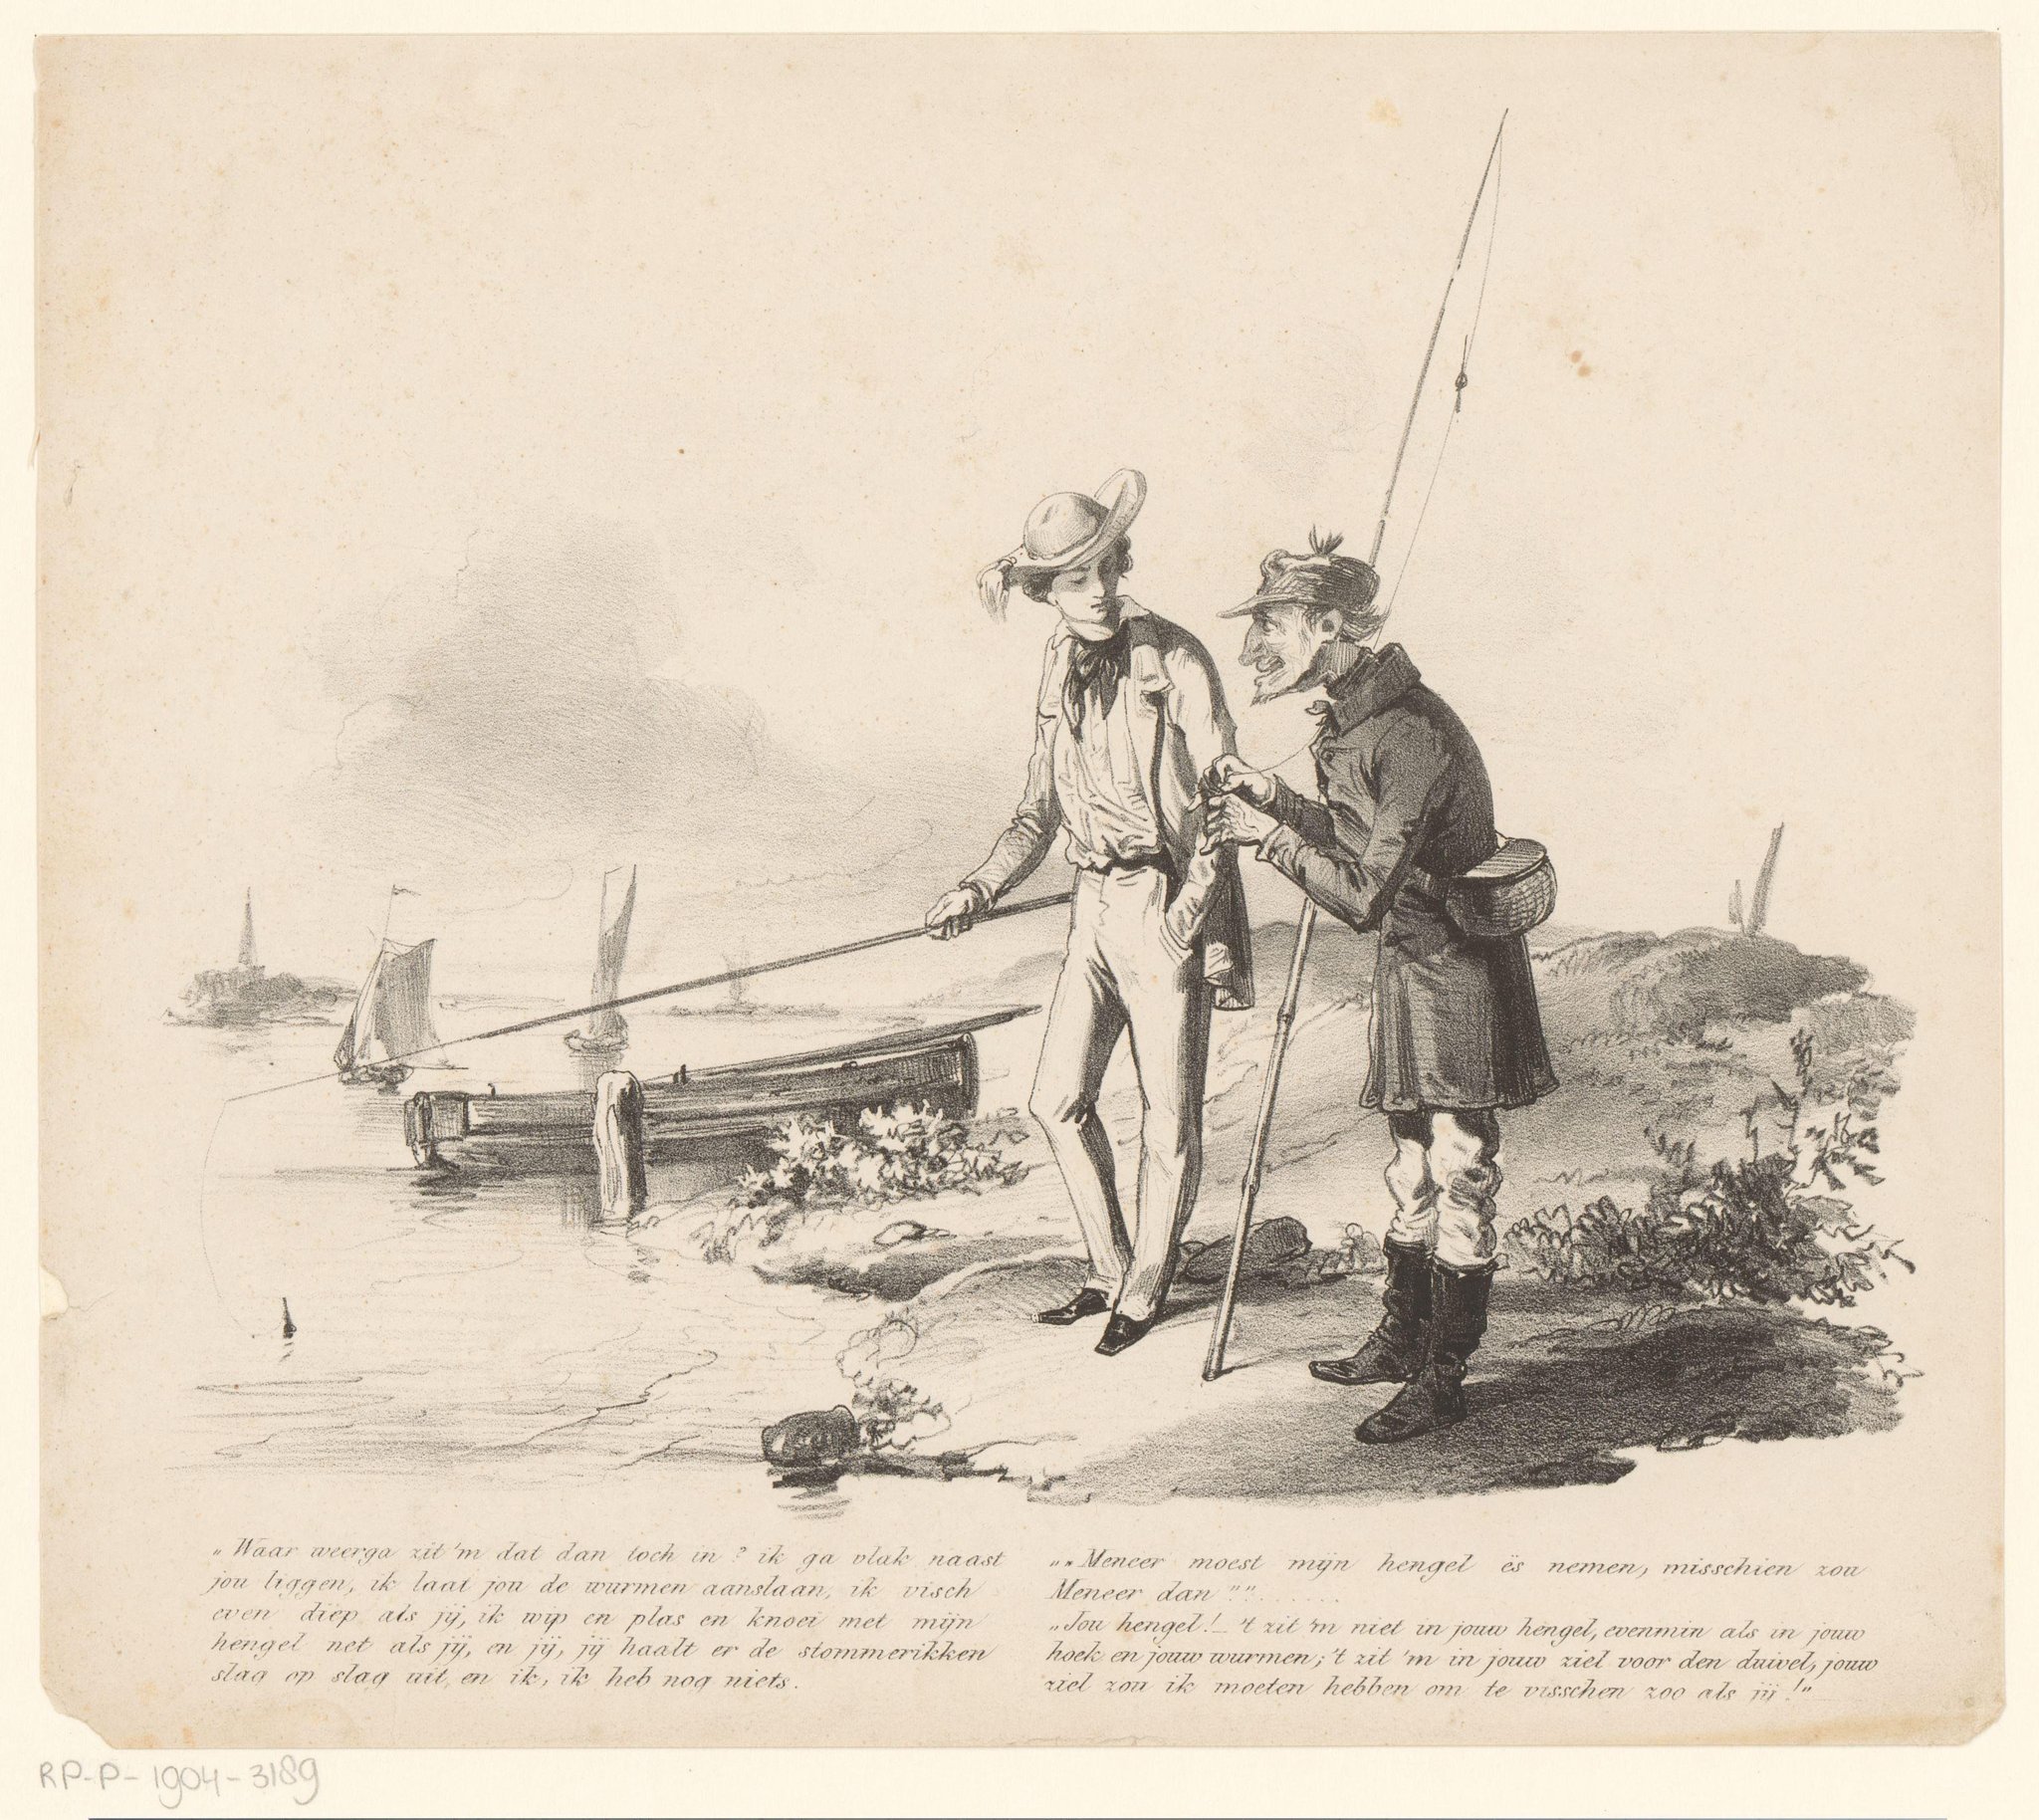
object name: print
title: Vissende jongeman en oude man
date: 1832-1897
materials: paper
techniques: lithograph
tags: fishing (sports)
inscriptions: collector's mark: Lugt 2228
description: Een vissende jongeman is in gesprek met een oude man die zijn aan de haak geslagen vis binnenhaalt.